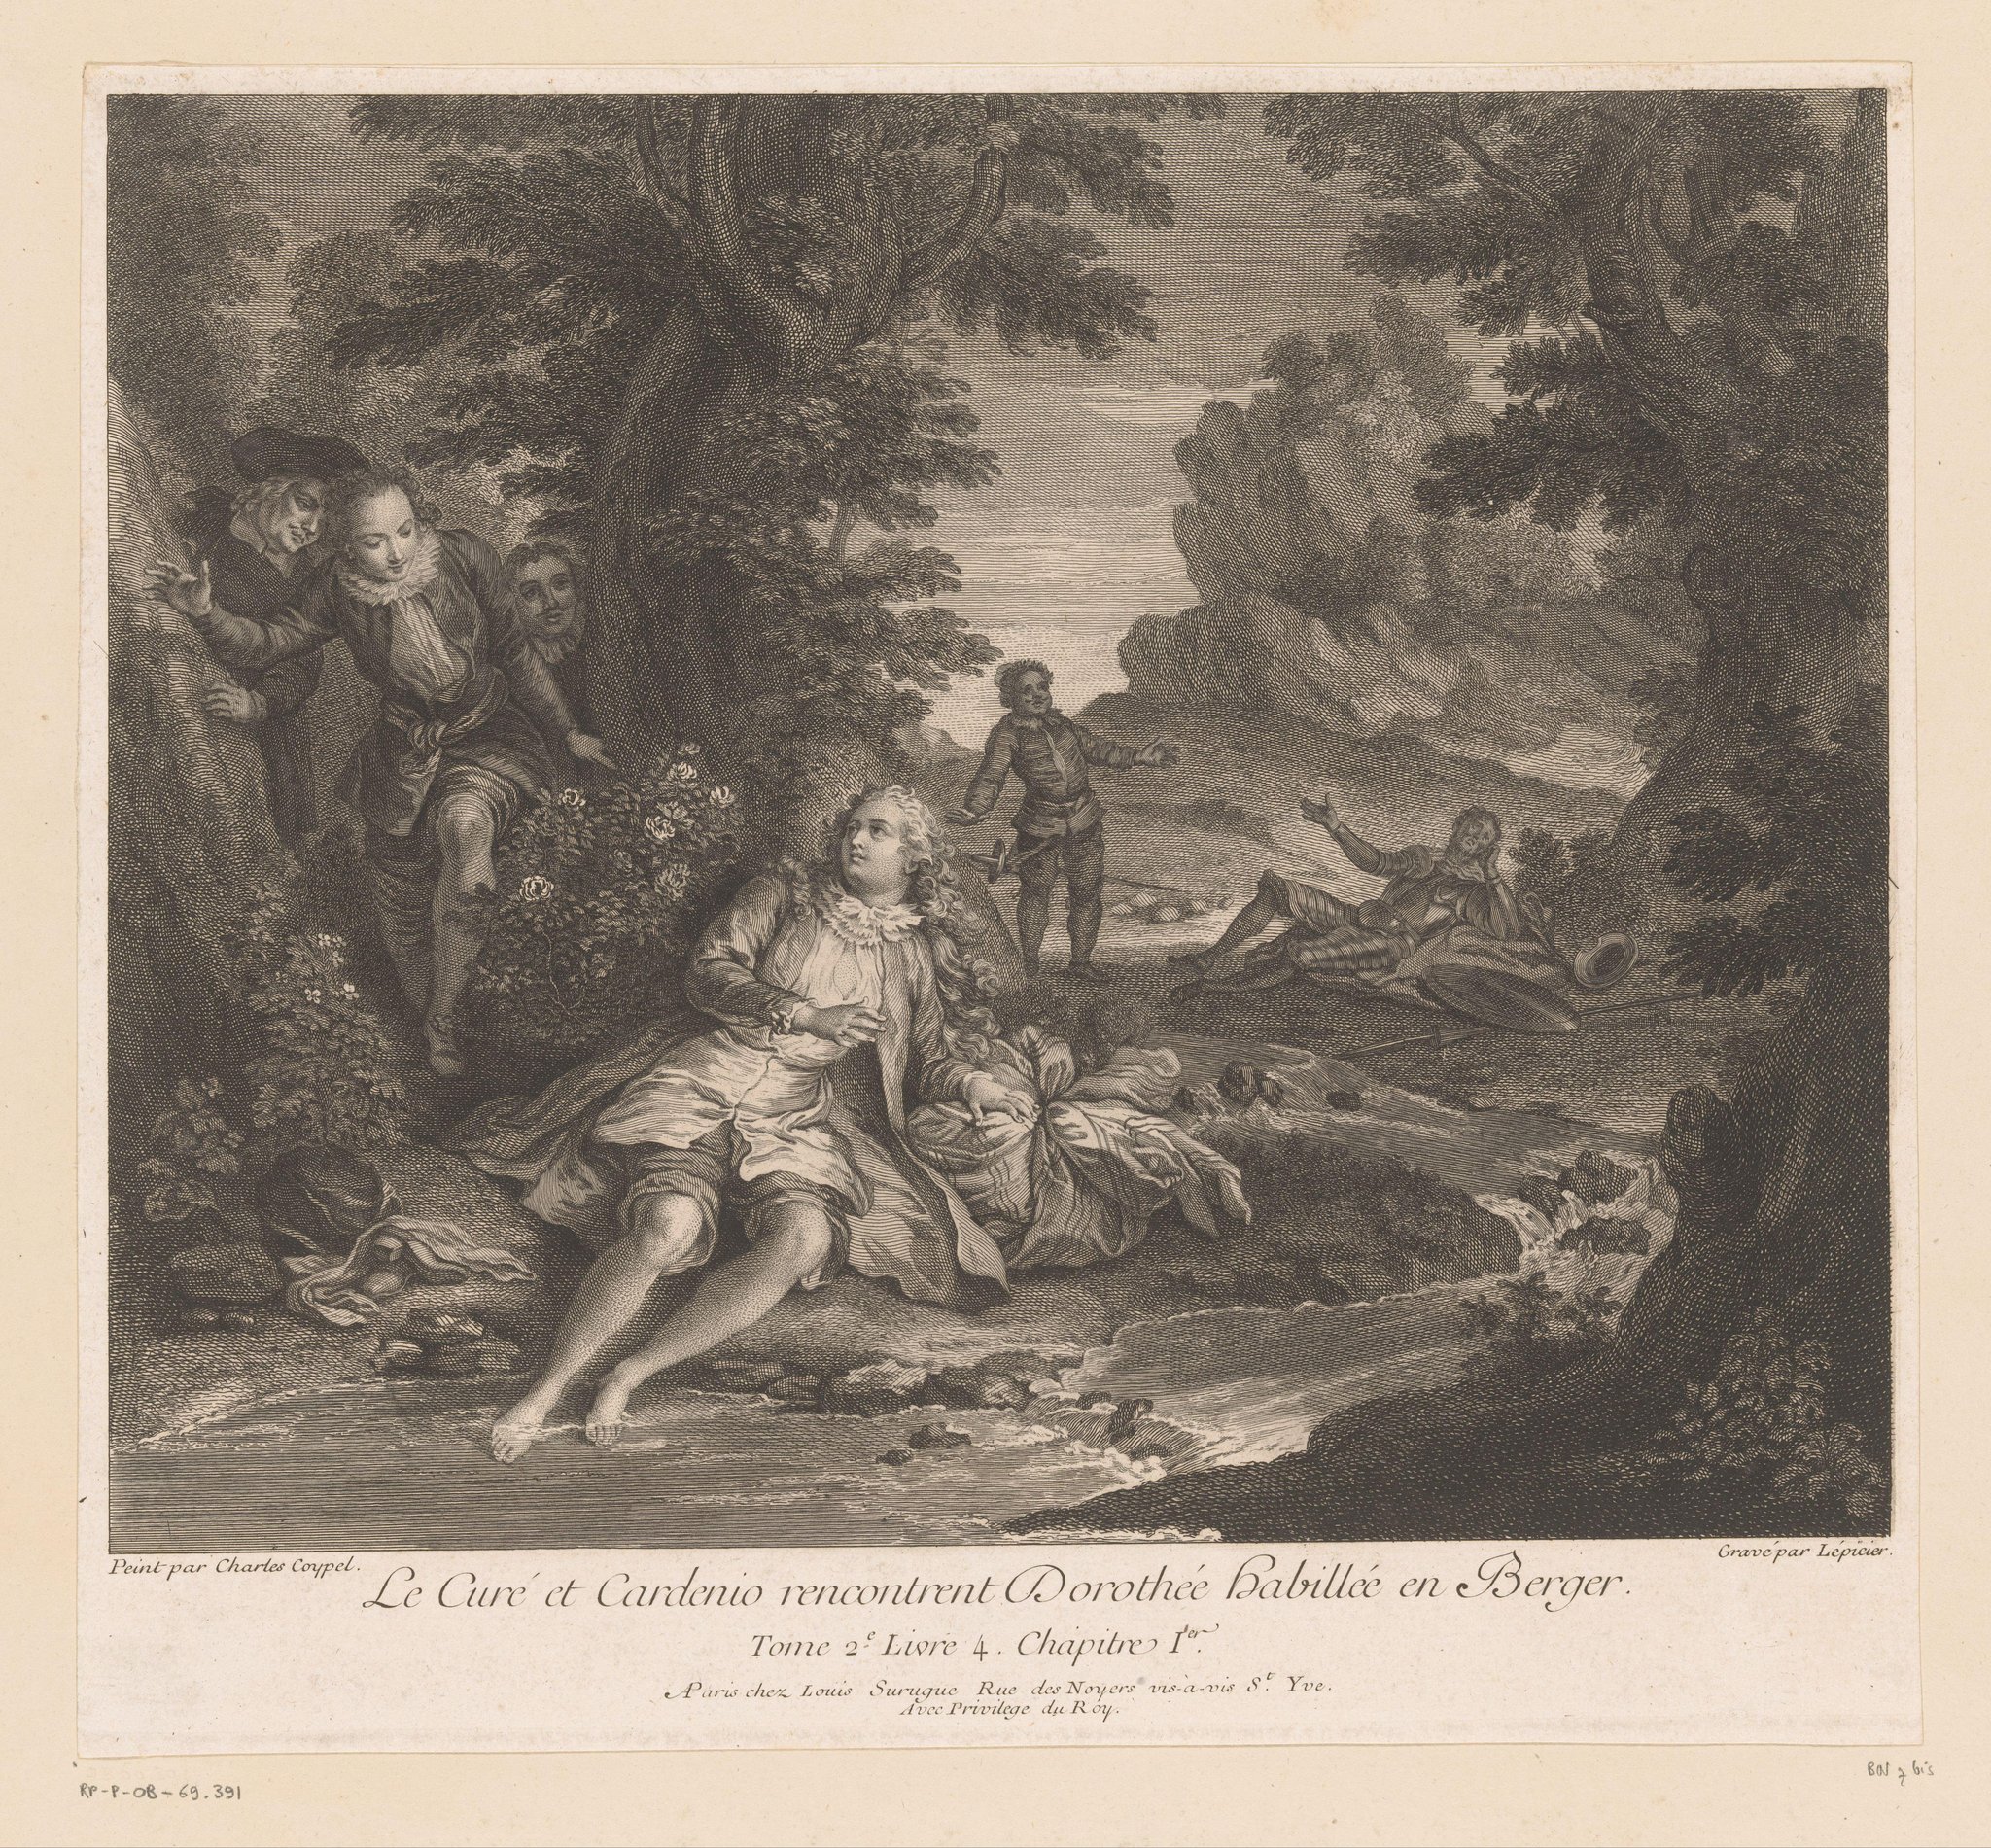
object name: print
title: Cardenio en de priester ontdekken Dorothée, verkleed als herder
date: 1724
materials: paper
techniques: engraving, etching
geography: france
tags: woman dressed as man, travesty, herding, herdsman, herdswoman, shepherd, shepherdess, cowherd, etc., don quixote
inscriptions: collector's mark: Lugt 240